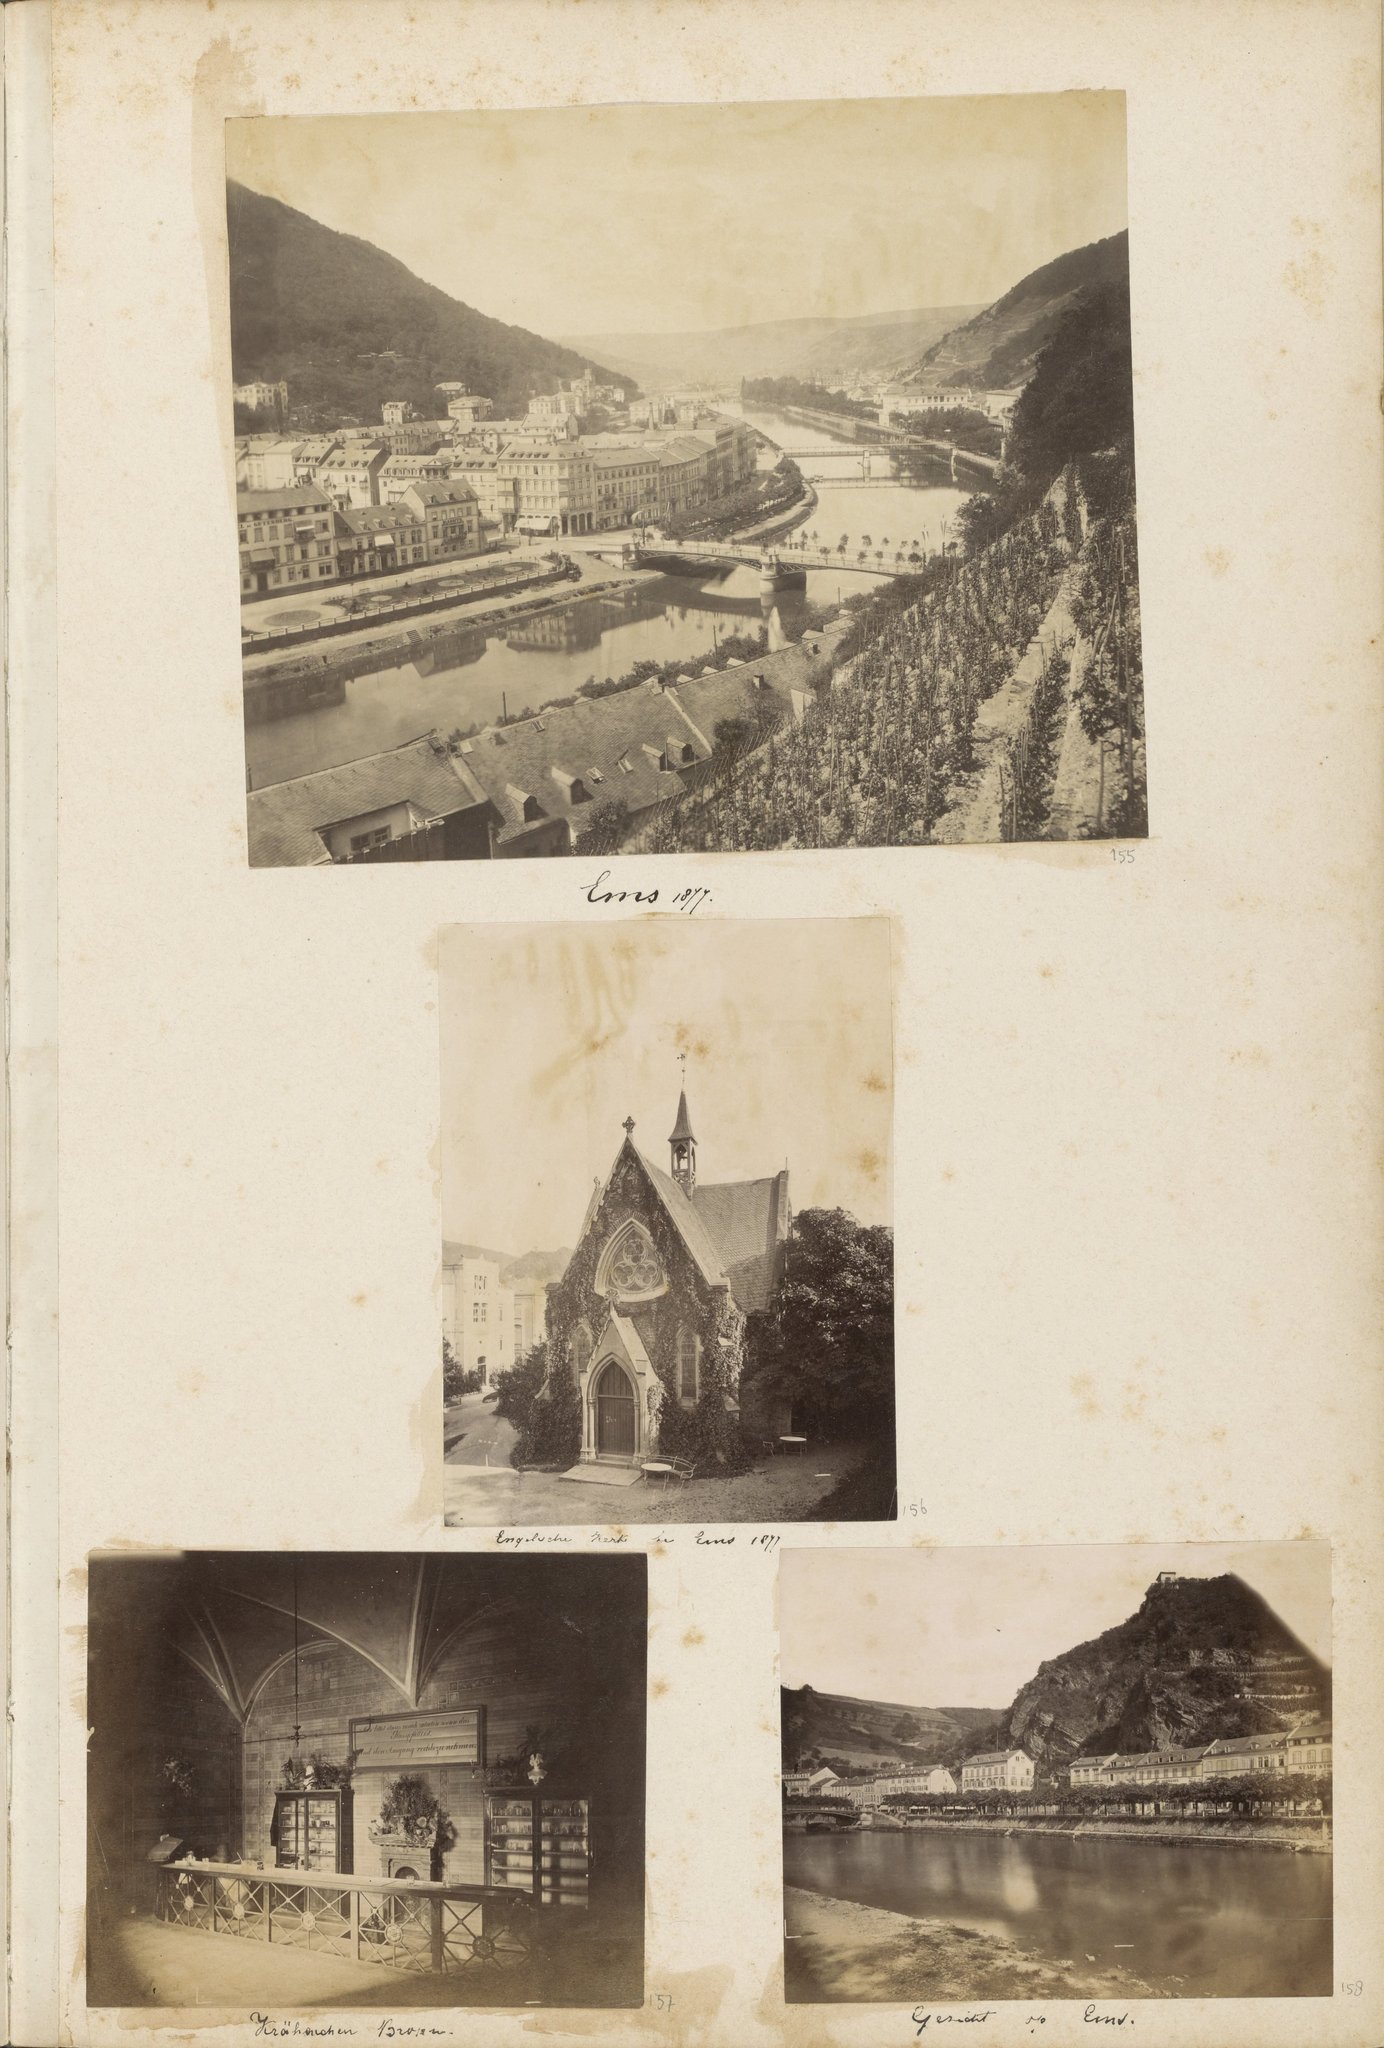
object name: album leaf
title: Gezicht op huizen langs de oever van de Lahn in Bad Ems met daarachter een berg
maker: Anonymous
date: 1870-1880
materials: paper, photographic support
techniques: albumen print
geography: bad ems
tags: prospect of village, silhouette of village, river bank, mountains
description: Onderdeel van Fotoalbum van Robert Daniel Crommelin (1841-1907).